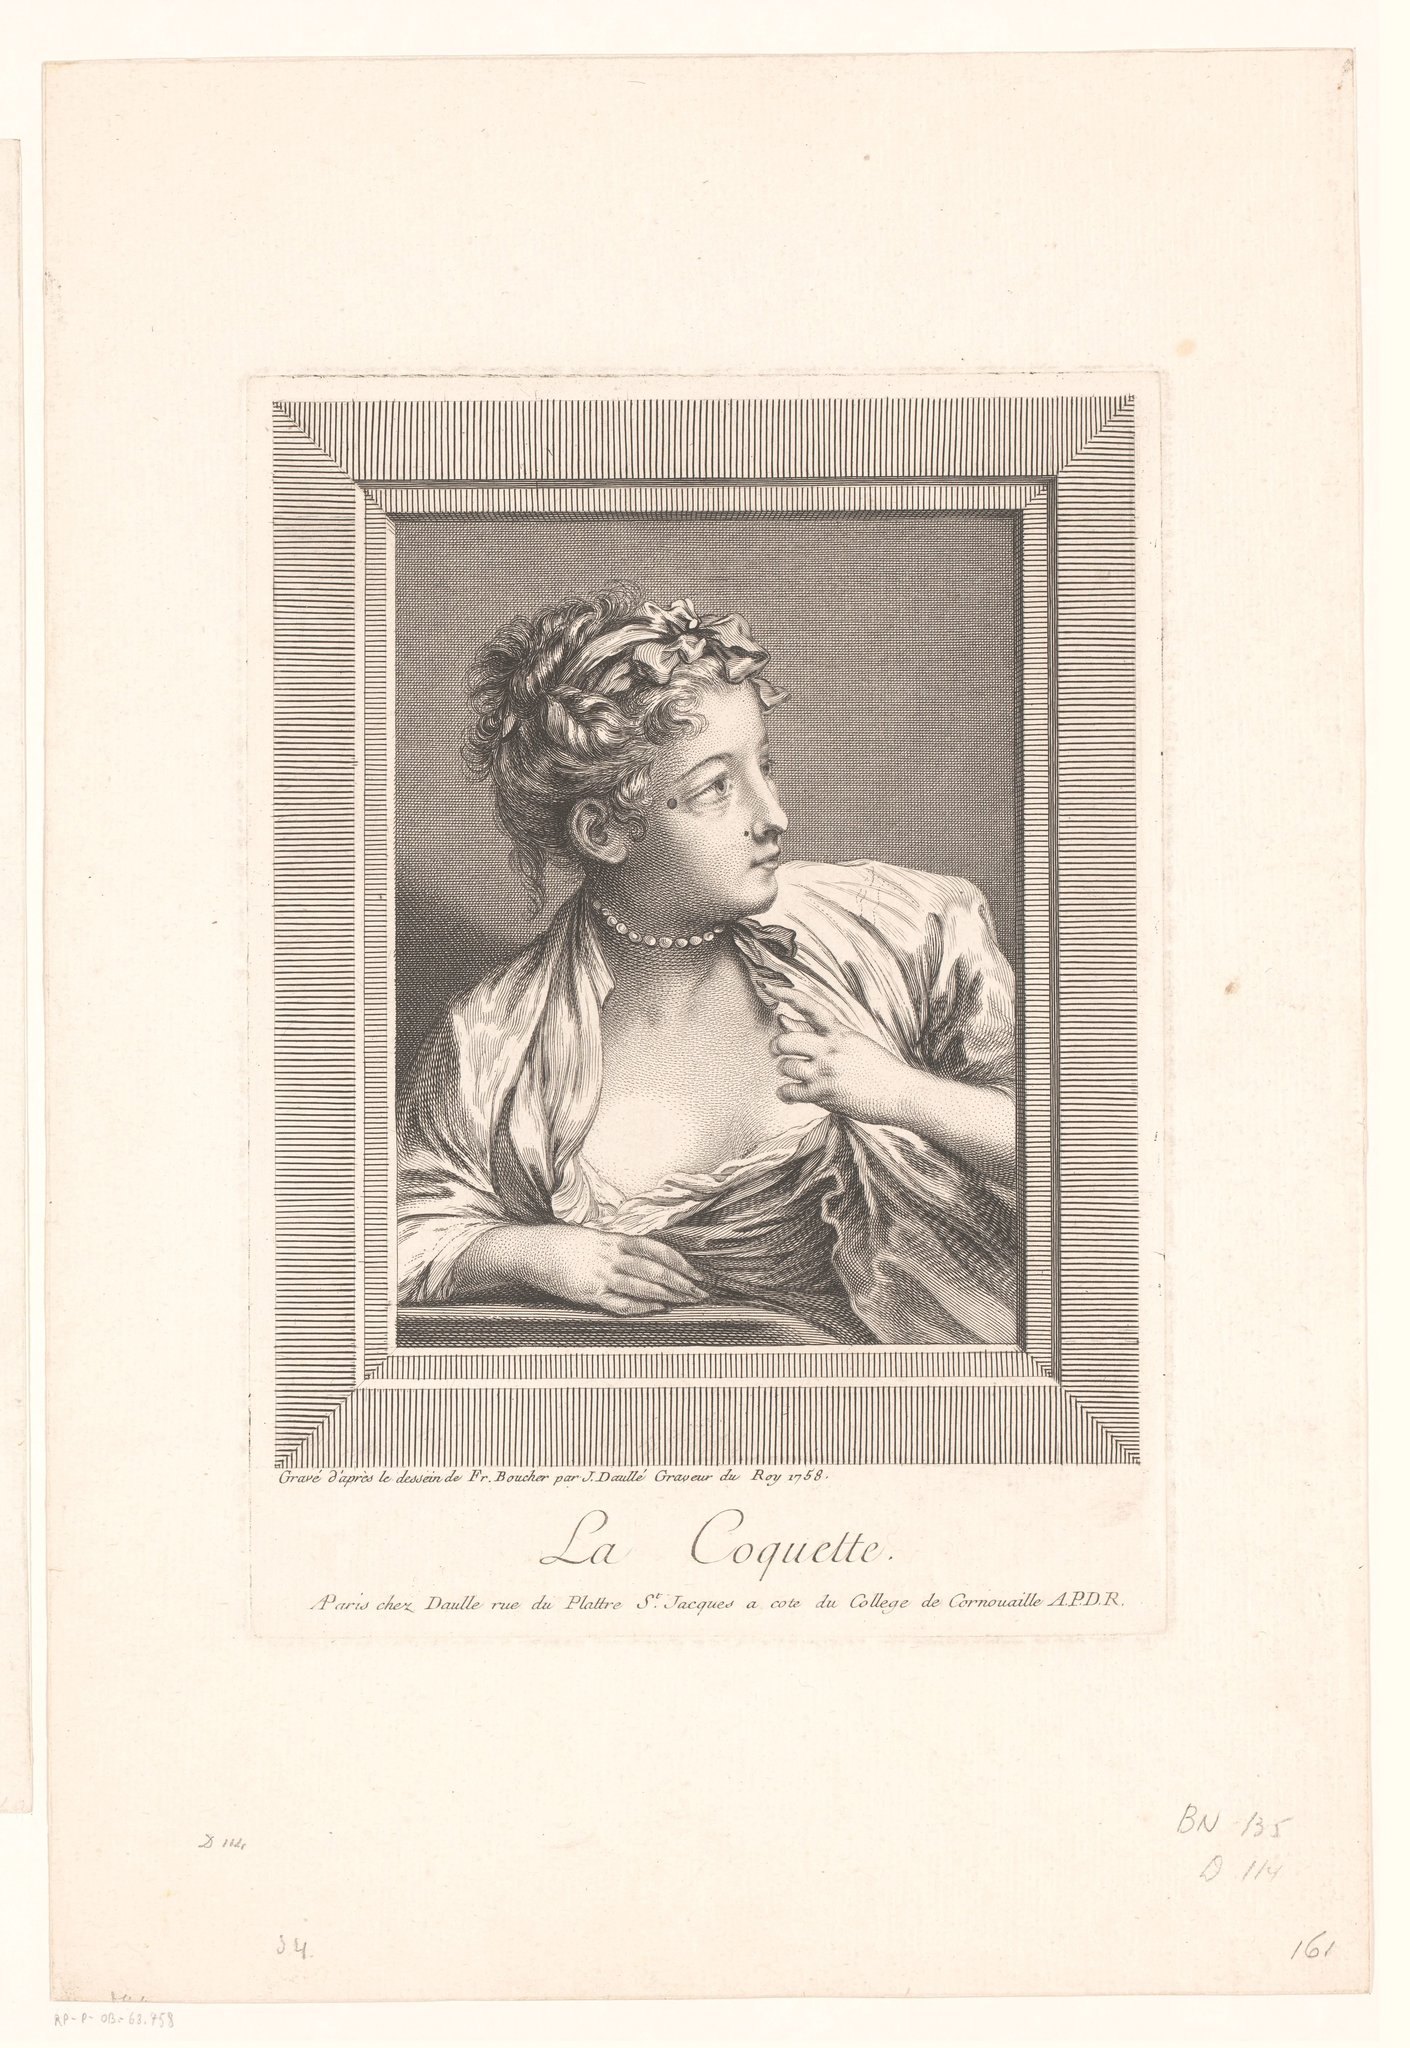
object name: print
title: Vrouw met strik in het haar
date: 1758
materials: paper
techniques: engraving, etching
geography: france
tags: adult woman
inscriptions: collector's mark: Lugt 240